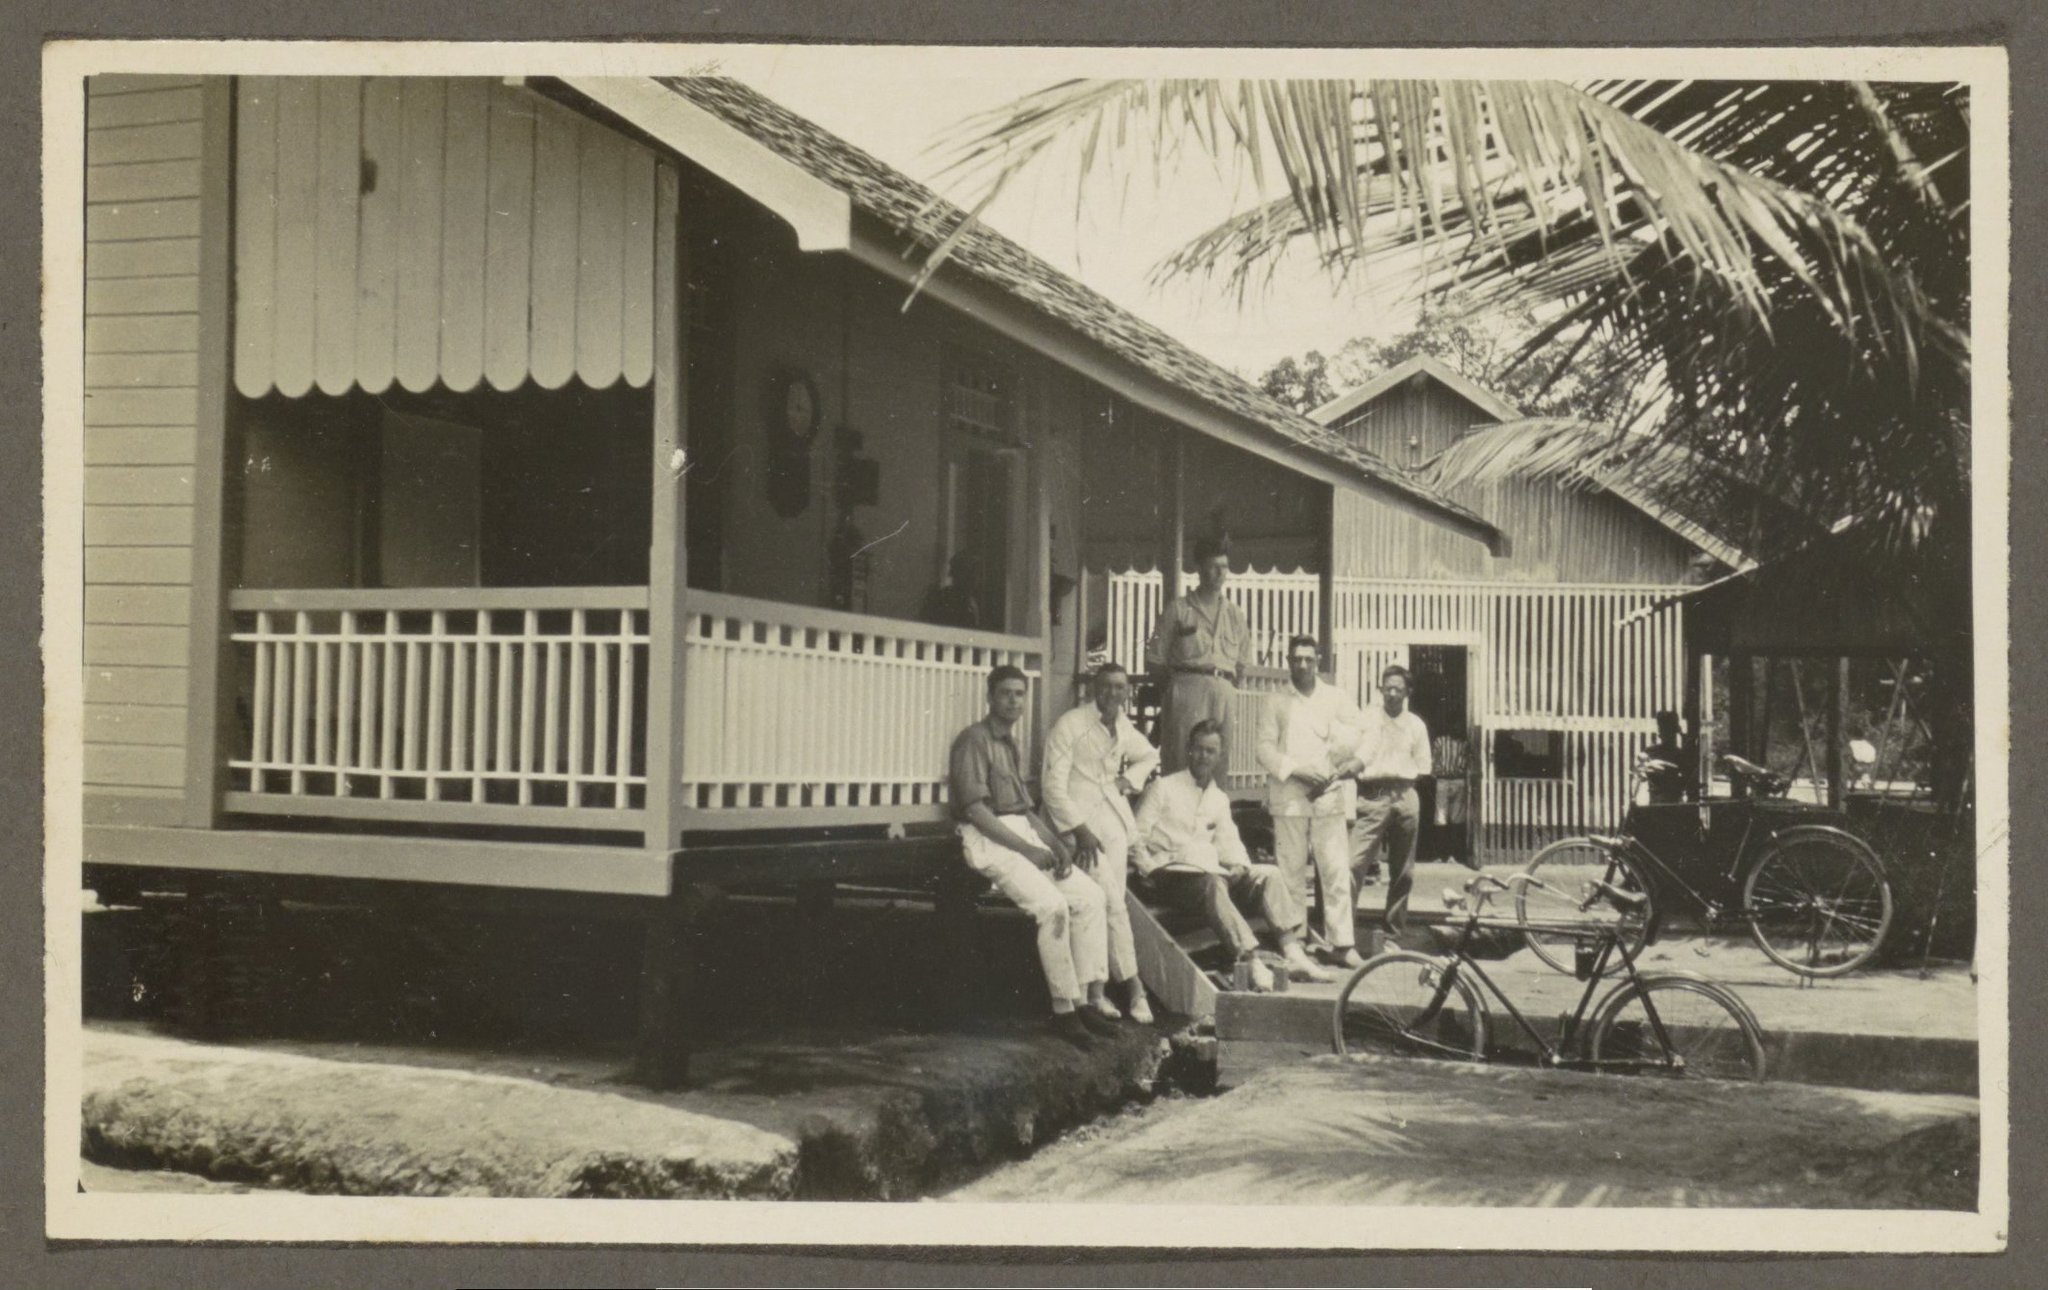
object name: photograph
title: Groep mannen poserend voor een houten huis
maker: Anonymous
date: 1920-1930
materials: photographic support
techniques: gelatin silver print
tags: sun-porch, sun-parlour, glazed verandah, bicycle, dutch east indies, the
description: Onderdeel van familiealbum Nederlands-Indië.